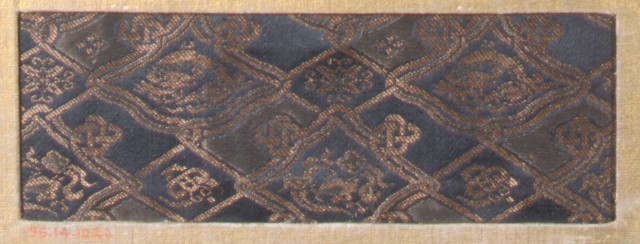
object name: piece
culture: japanese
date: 1701-1900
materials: silk